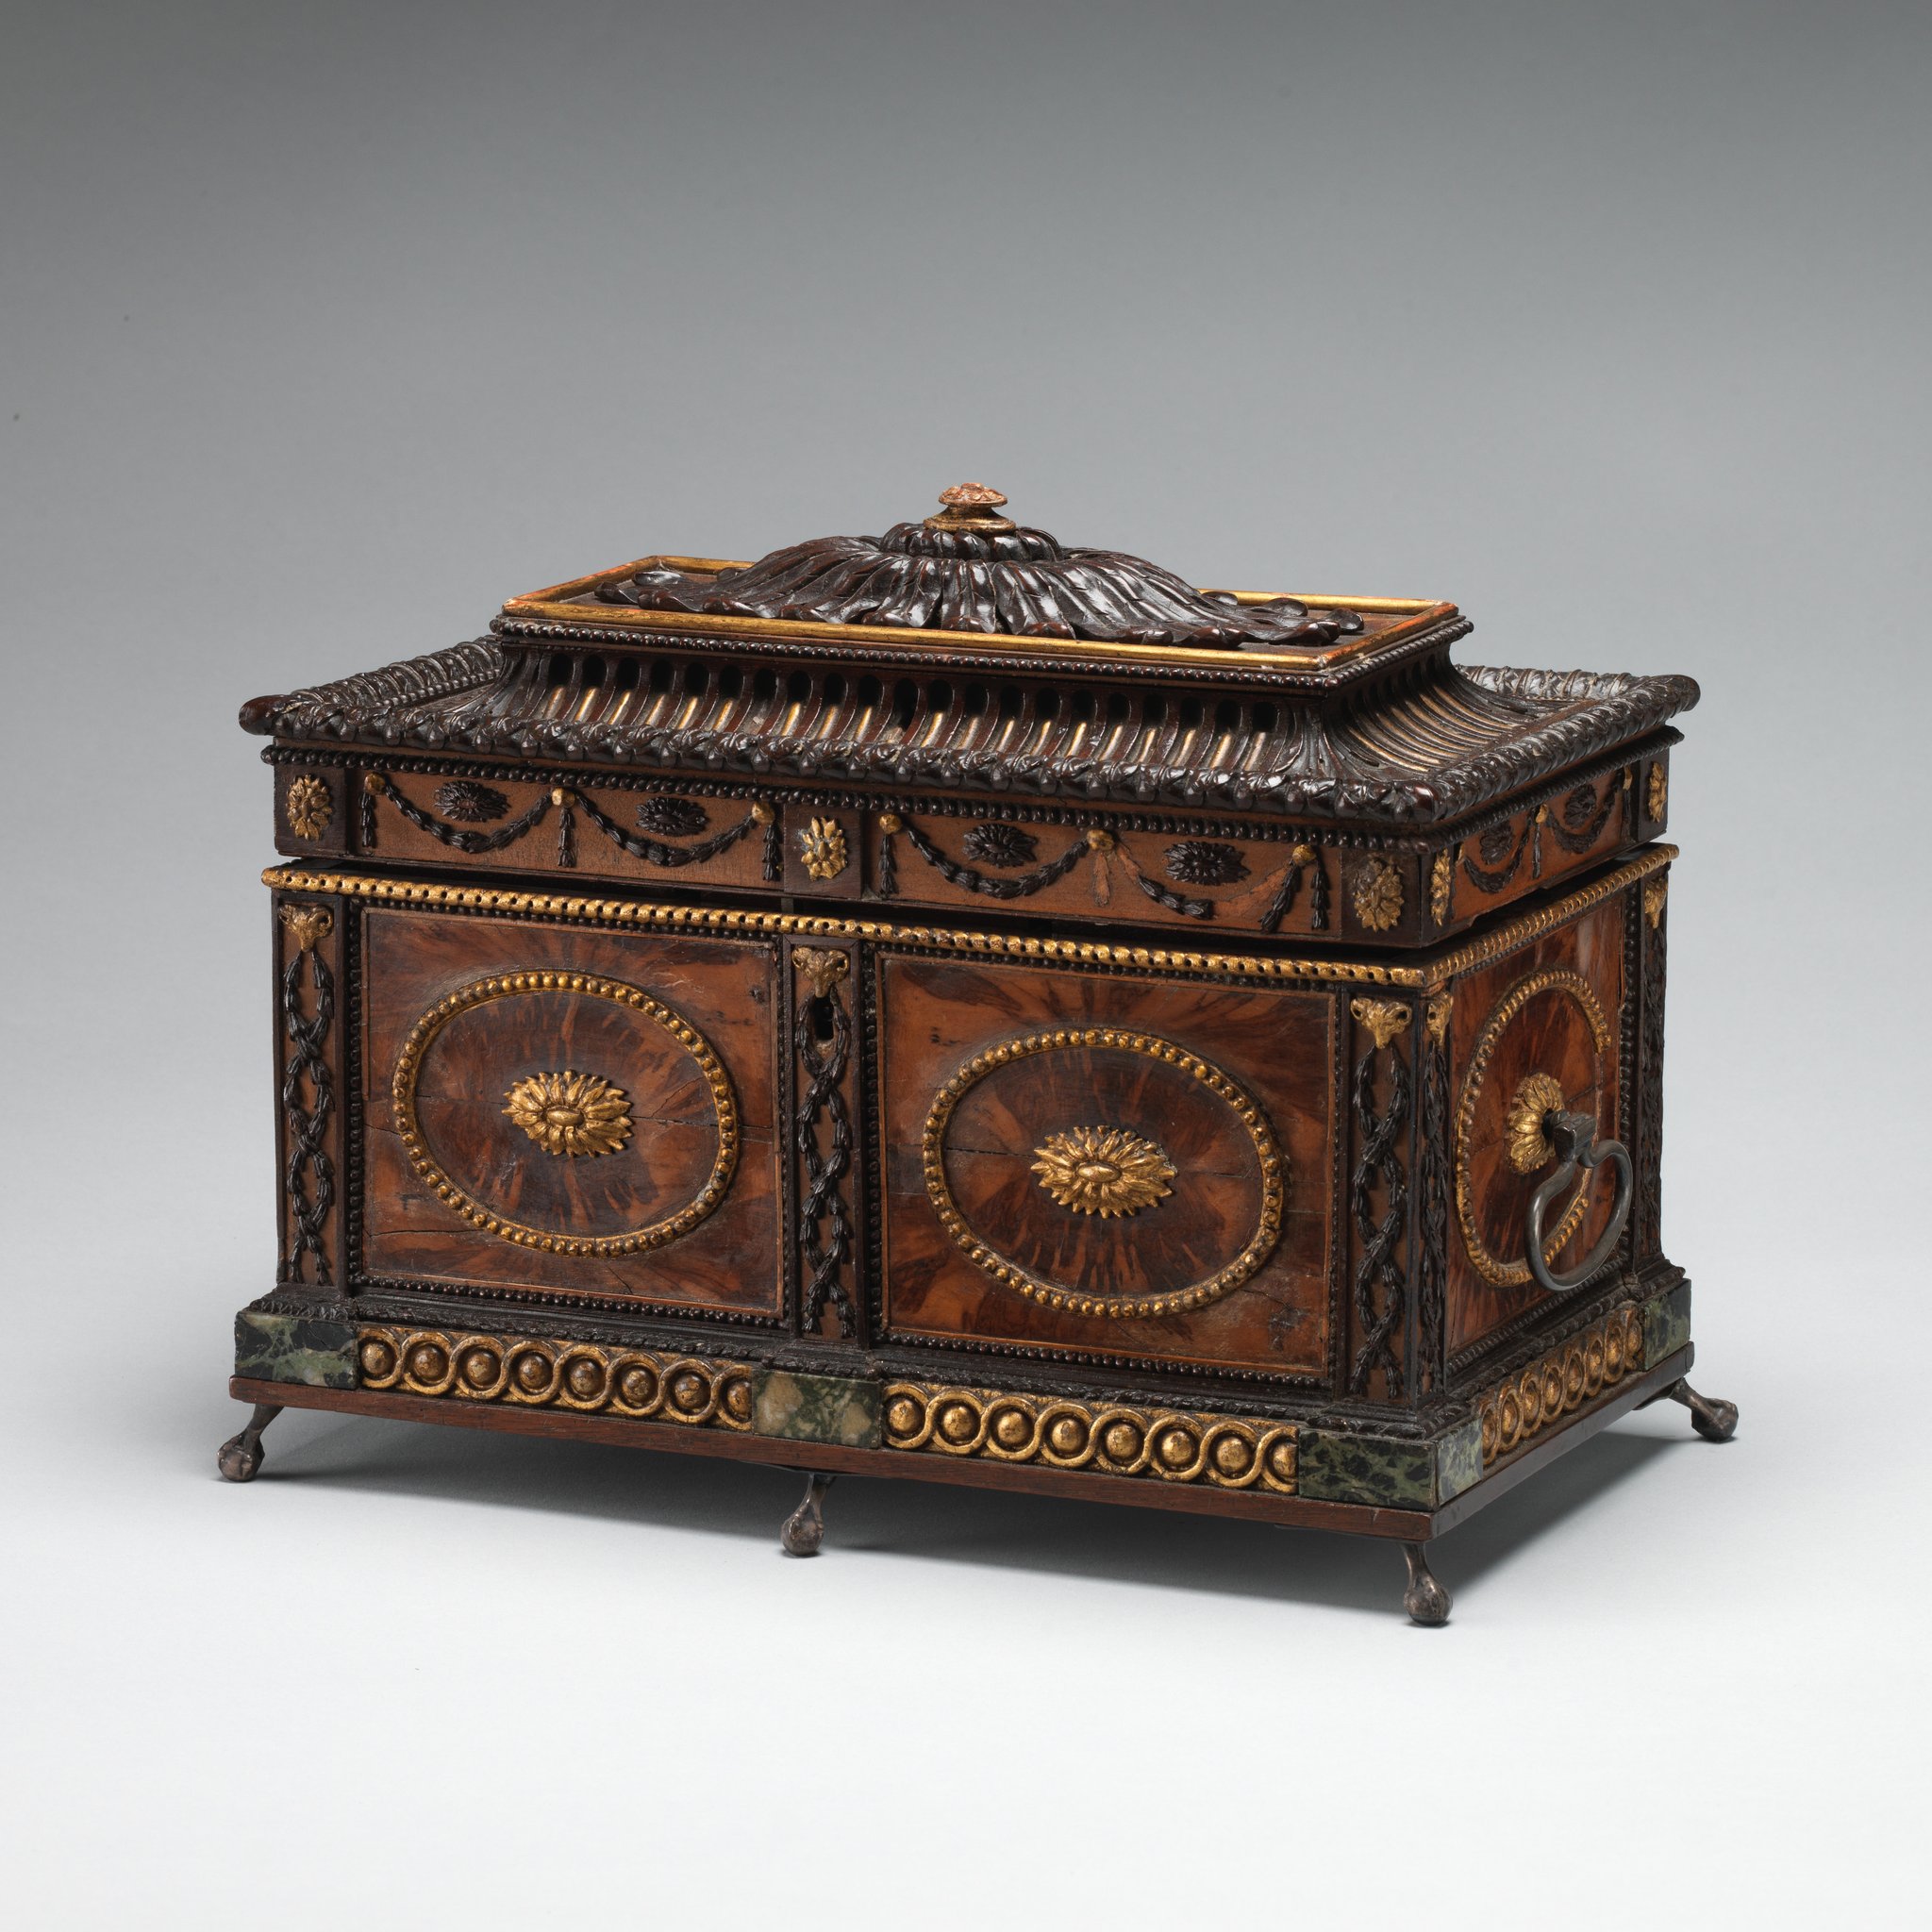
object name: tea chest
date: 1780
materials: gilt, wood, marble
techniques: veneering